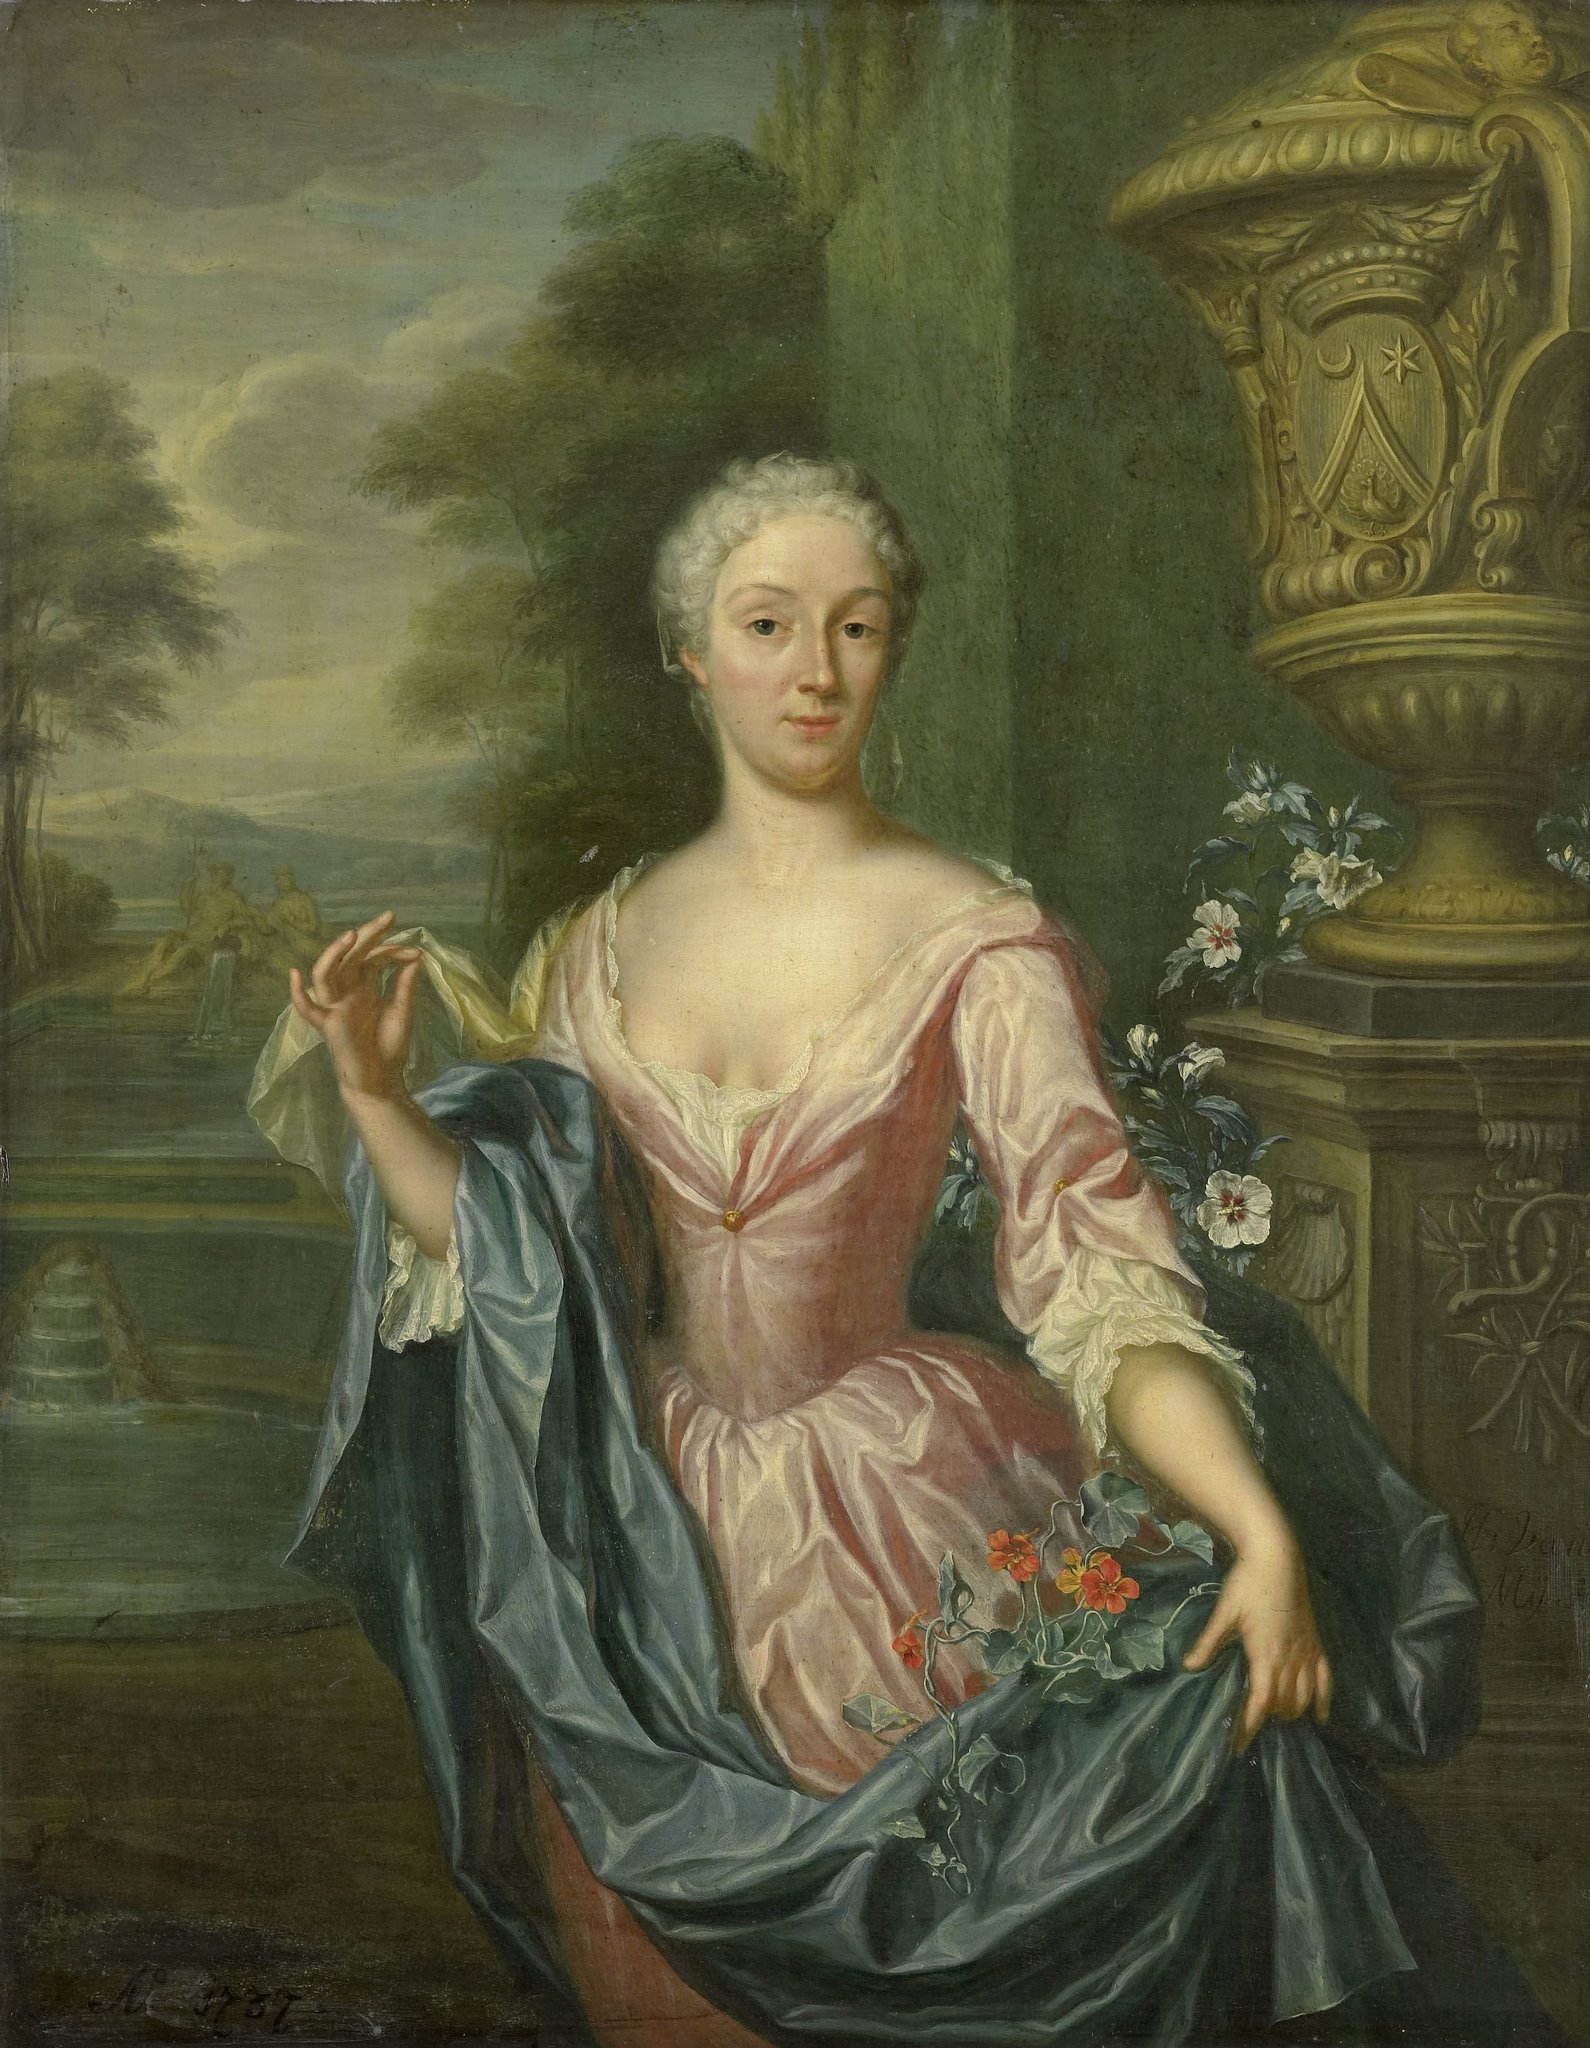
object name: painting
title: Portrait of Claudine van Royen (born 1712), Wife of Pieter Teding van Berkhout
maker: hieronymus van der mij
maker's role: painter, print maker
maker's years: 1687-1761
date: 1757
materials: oil, panel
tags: historical persons - bb - woman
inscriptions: inscription: ‘mevr Claudina van Royen geb. 1712, 10 Jan. 1734, 23 Febr. Pieter Teding v. Berkhout’, signature and date: ‘H: van d. Mij fec Aº 1757’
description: Portret van Claudine van Royen, echtgenote van Pieter Teding van Berkhout. Kniestuk, staande naast een grote tuinvaas, links een tuin met fontein en vijver.